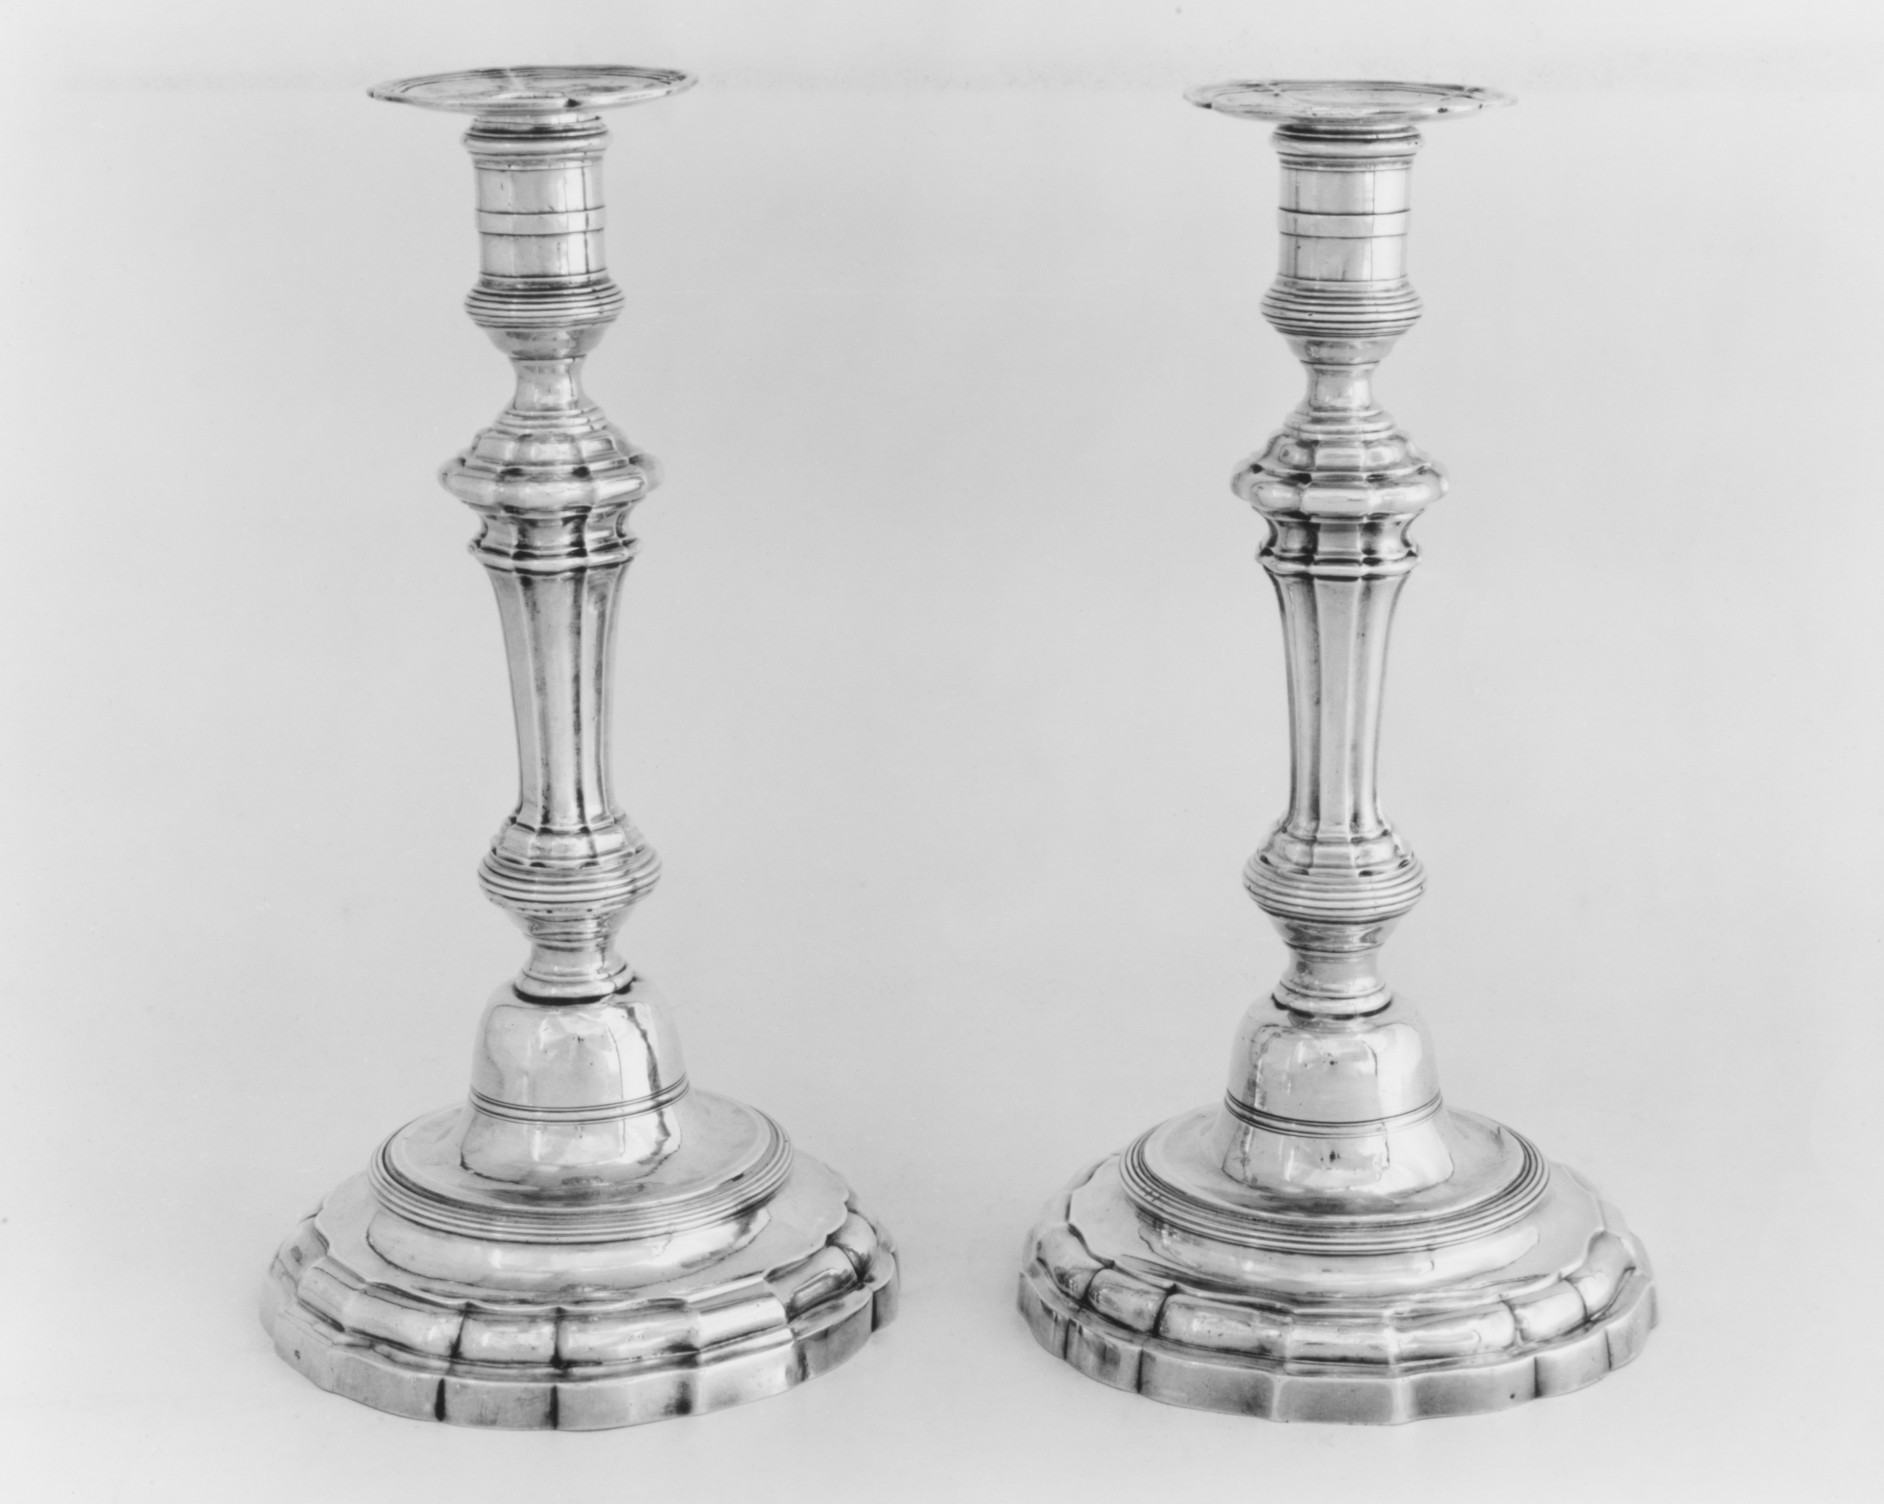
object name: candlestick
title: Pair of candlesticks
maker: françois thomas germain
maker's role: maker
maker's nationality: french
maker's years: 1726-1791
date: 1757-1759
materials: silver